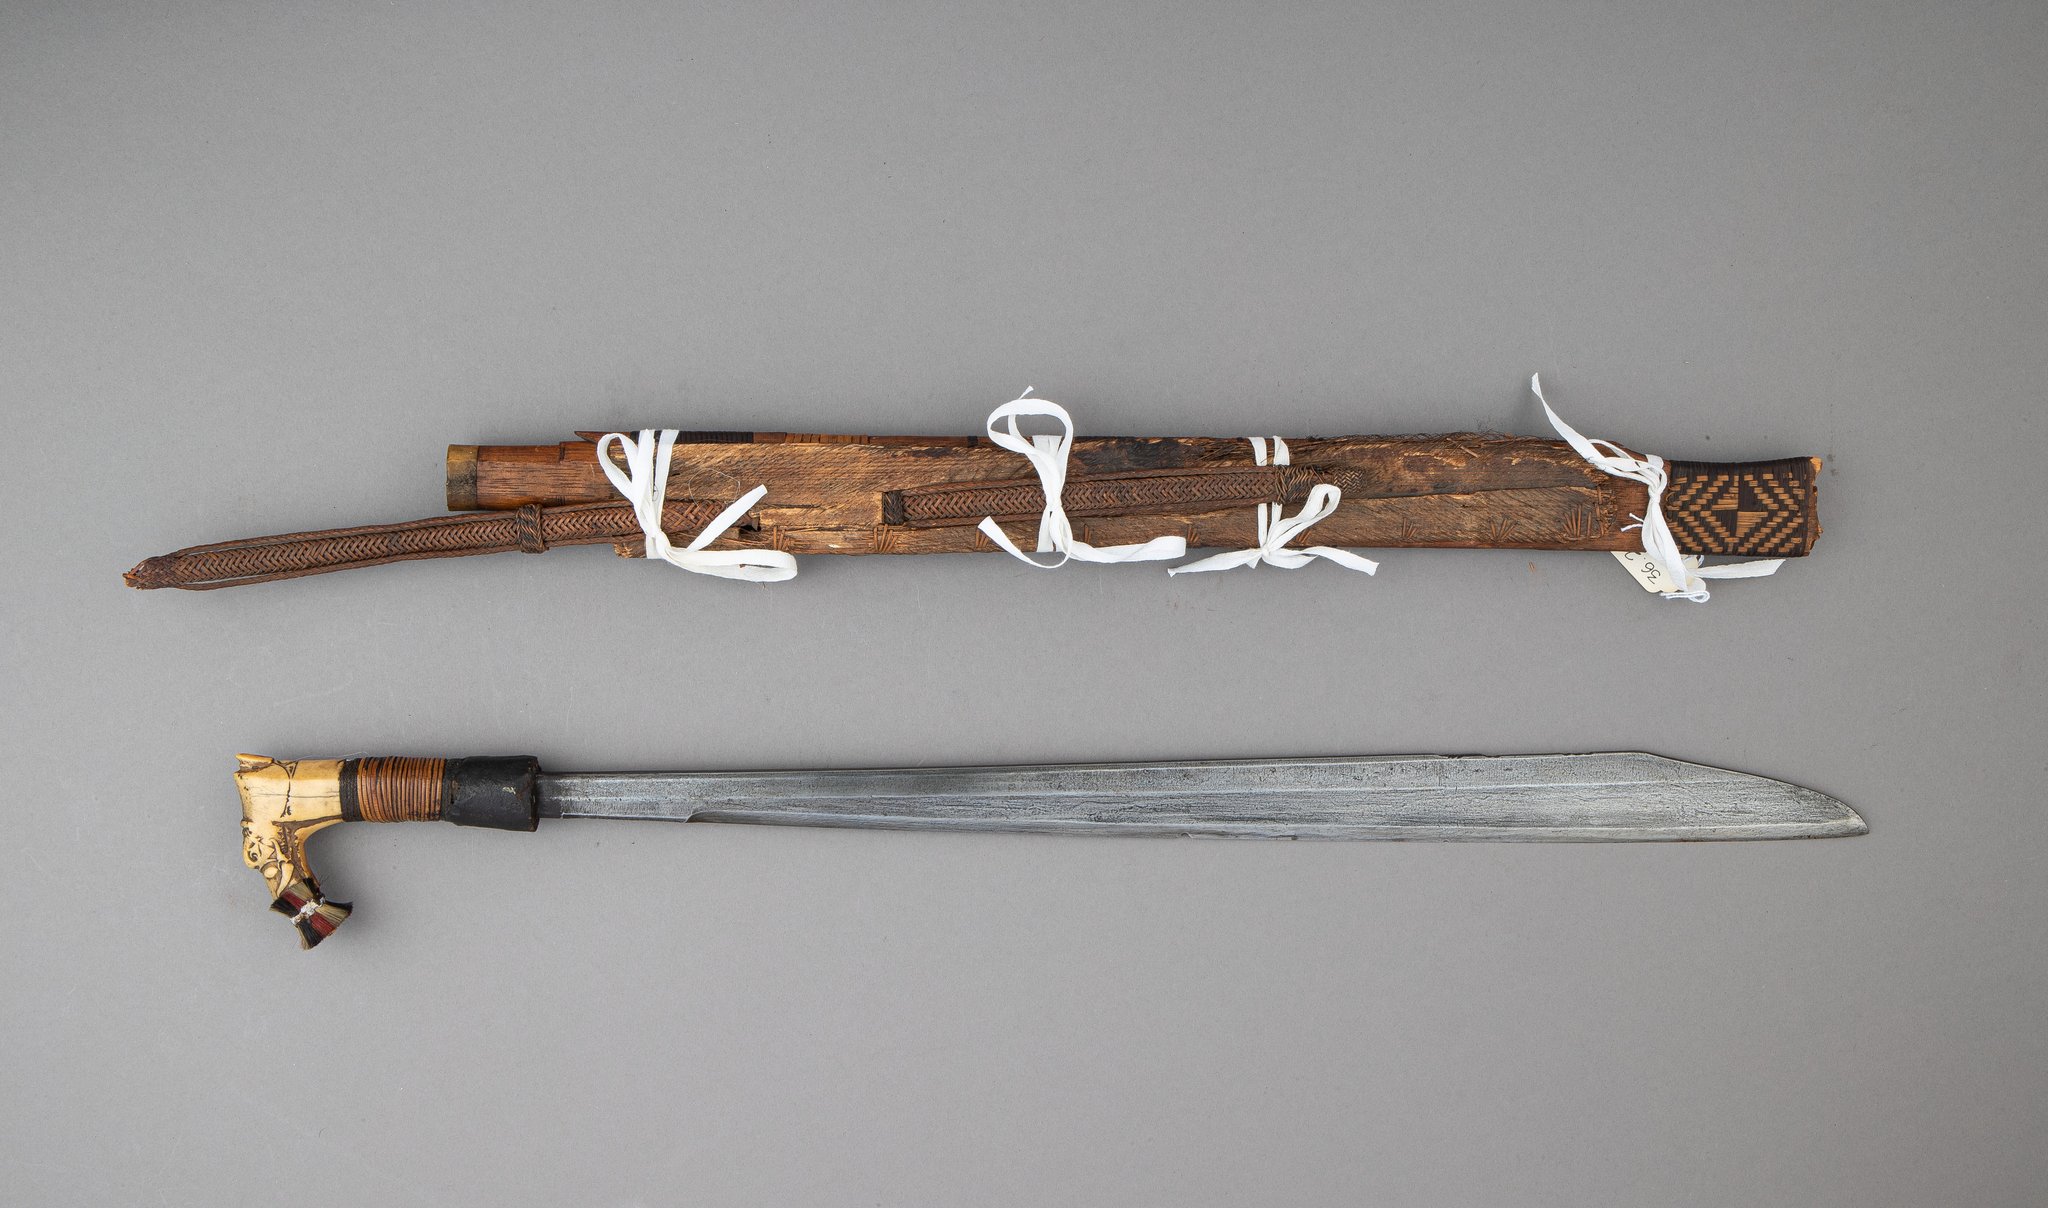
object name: sword mandau with scabbard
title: Sword (Mandau) with Scabbard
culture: dyak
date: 1701-1900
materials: bone, horn, wood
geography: borneo